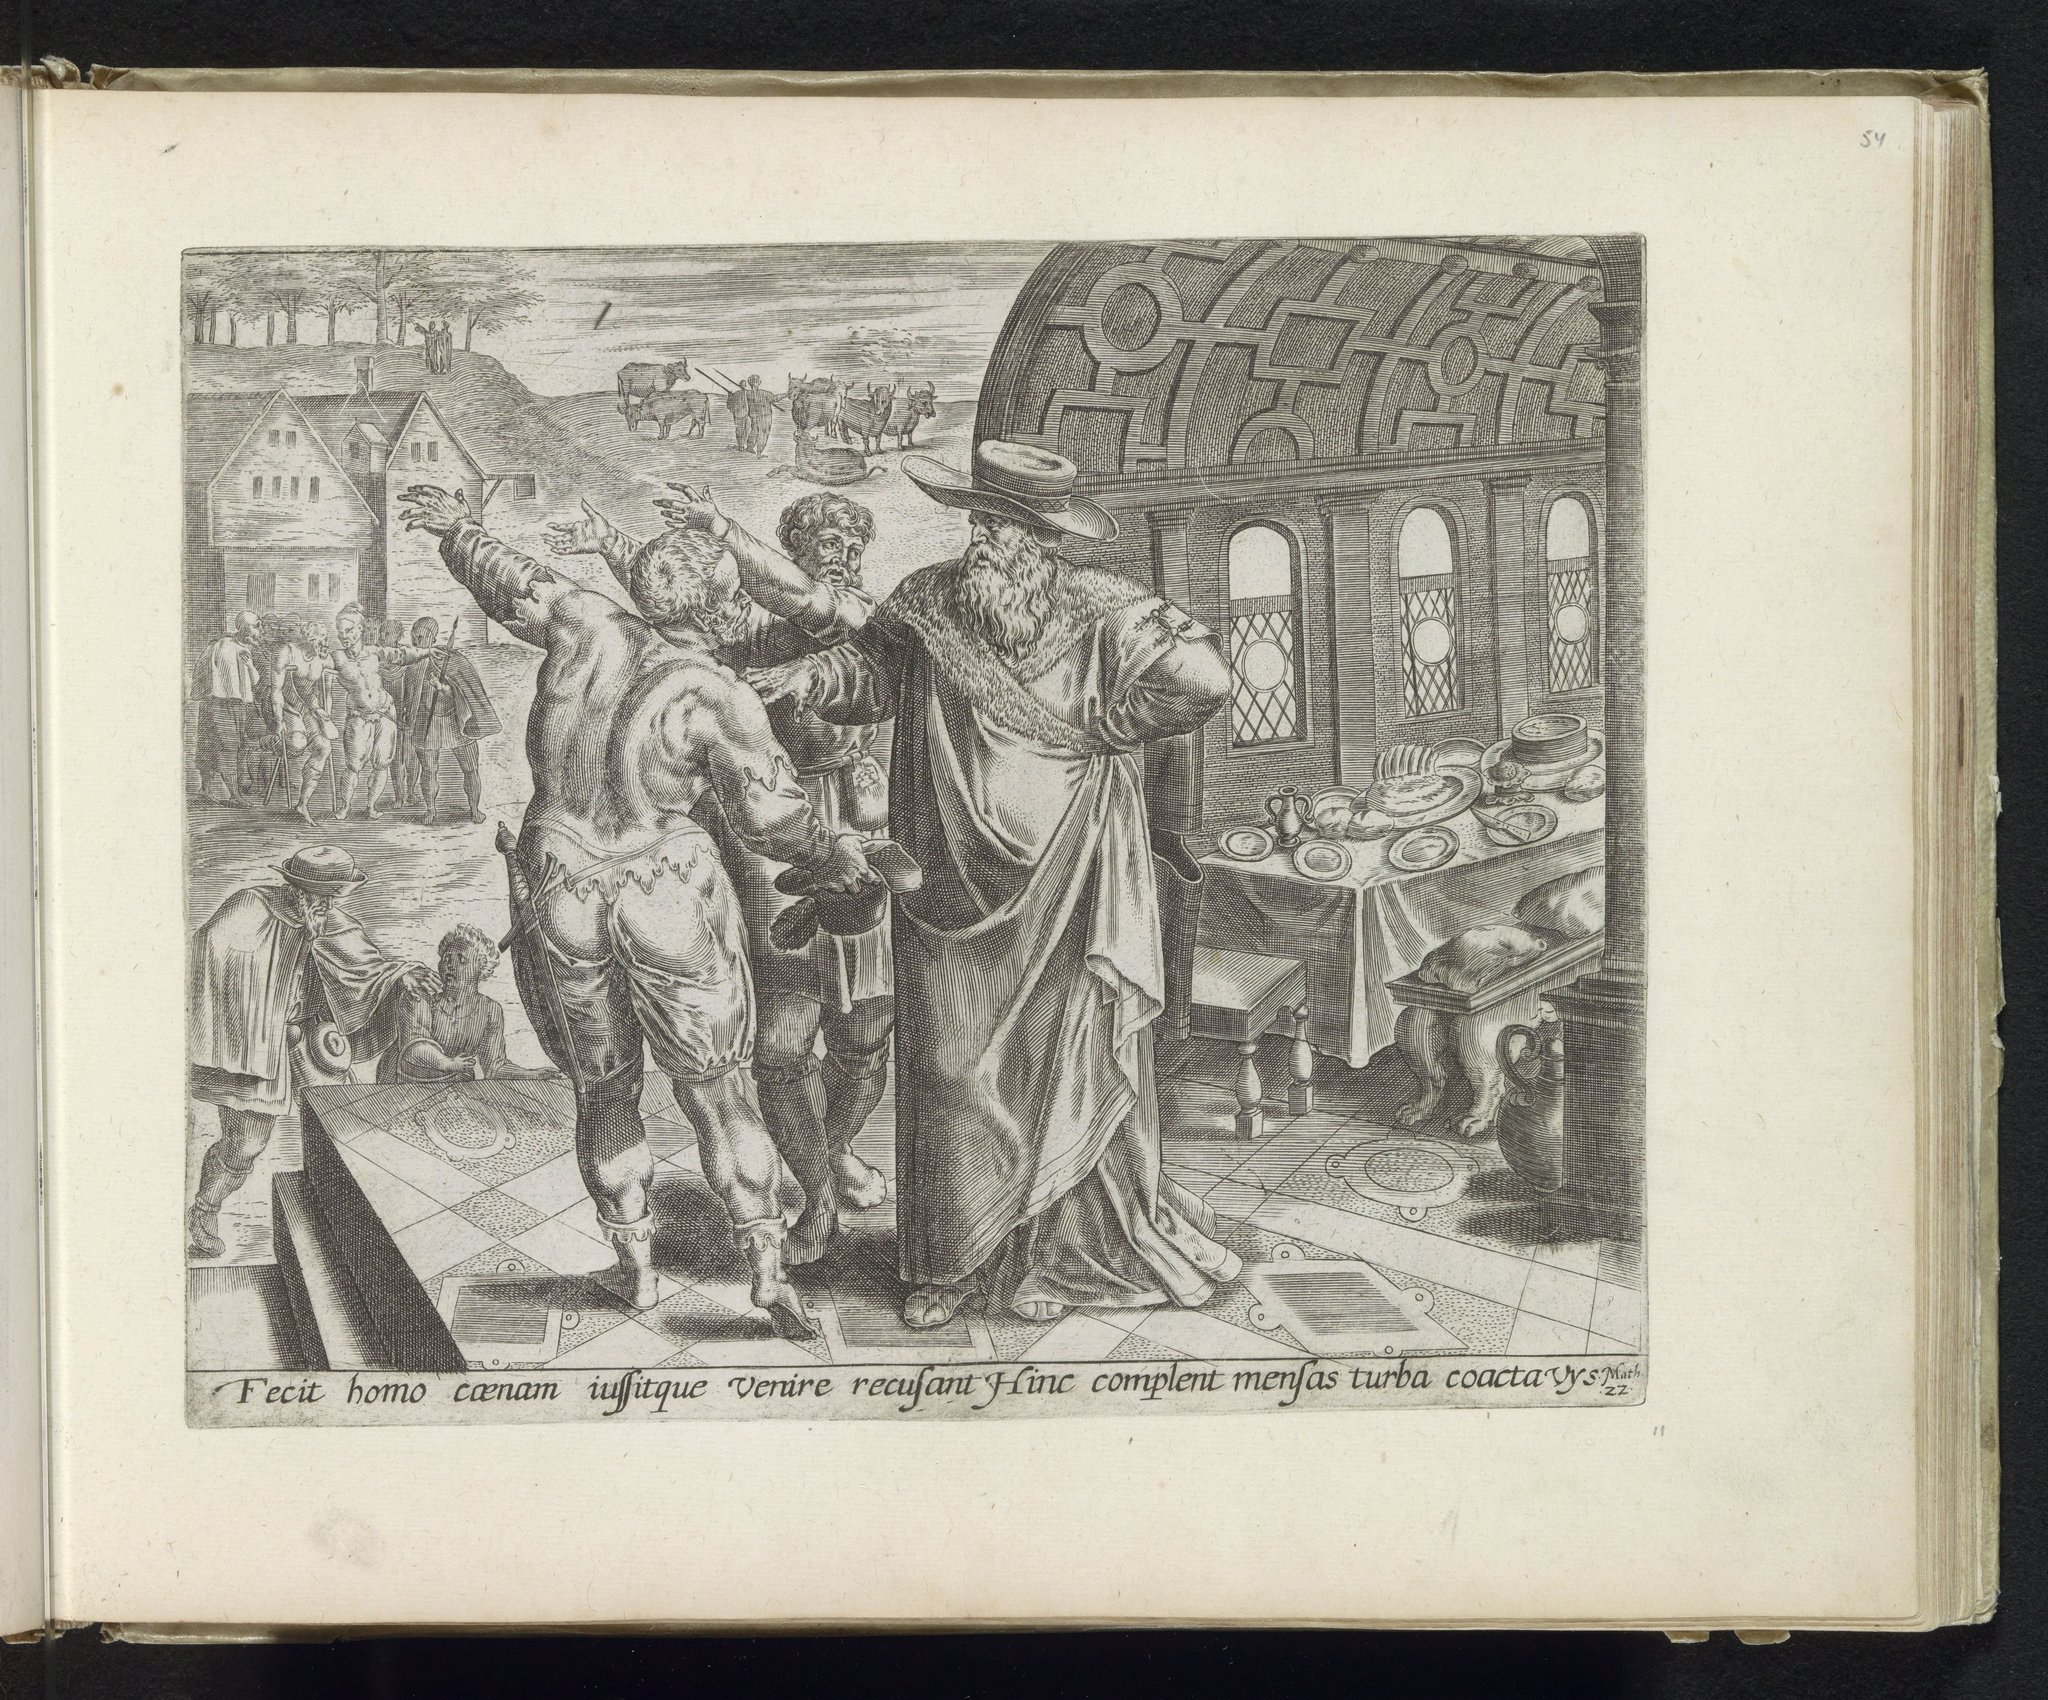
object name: album leaf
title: Gelijkenis van het koninklijke bruiloftsfeest: de uitnodiging van de koning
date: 1585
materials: paper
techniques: engraving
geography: antwerp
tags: disabilities, deformations, the great supper; the royal wedding-feast ~ parable of christ (matthew 22:1-14; luke 14:16-24)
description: Een koning heeft zijn dienaren de opdracht gegeven om de bruiloftsgasten uit te nodigen voor het bruiloftsfeest van zijn zoon. De tafel is al gedekt. De twee dienaren die bij hem staan vertellen hem echter dat de gasten weigeren te komen, omdat ze andere zaken te doen hebben. Op de achtergrond gaan de genodigden naar hun akkers. Daarop geeft de koning de dienaren de opdracht om iedereen op straat uit te nodigen. Links worden de mensen van de straat, onder andere kreupelen, uitgenodigd. Onder de voorstelling een verwijzing in het Latijn naar de Bijbeltekst in Mat. 22. Deze prent maakt deel uit van een album.